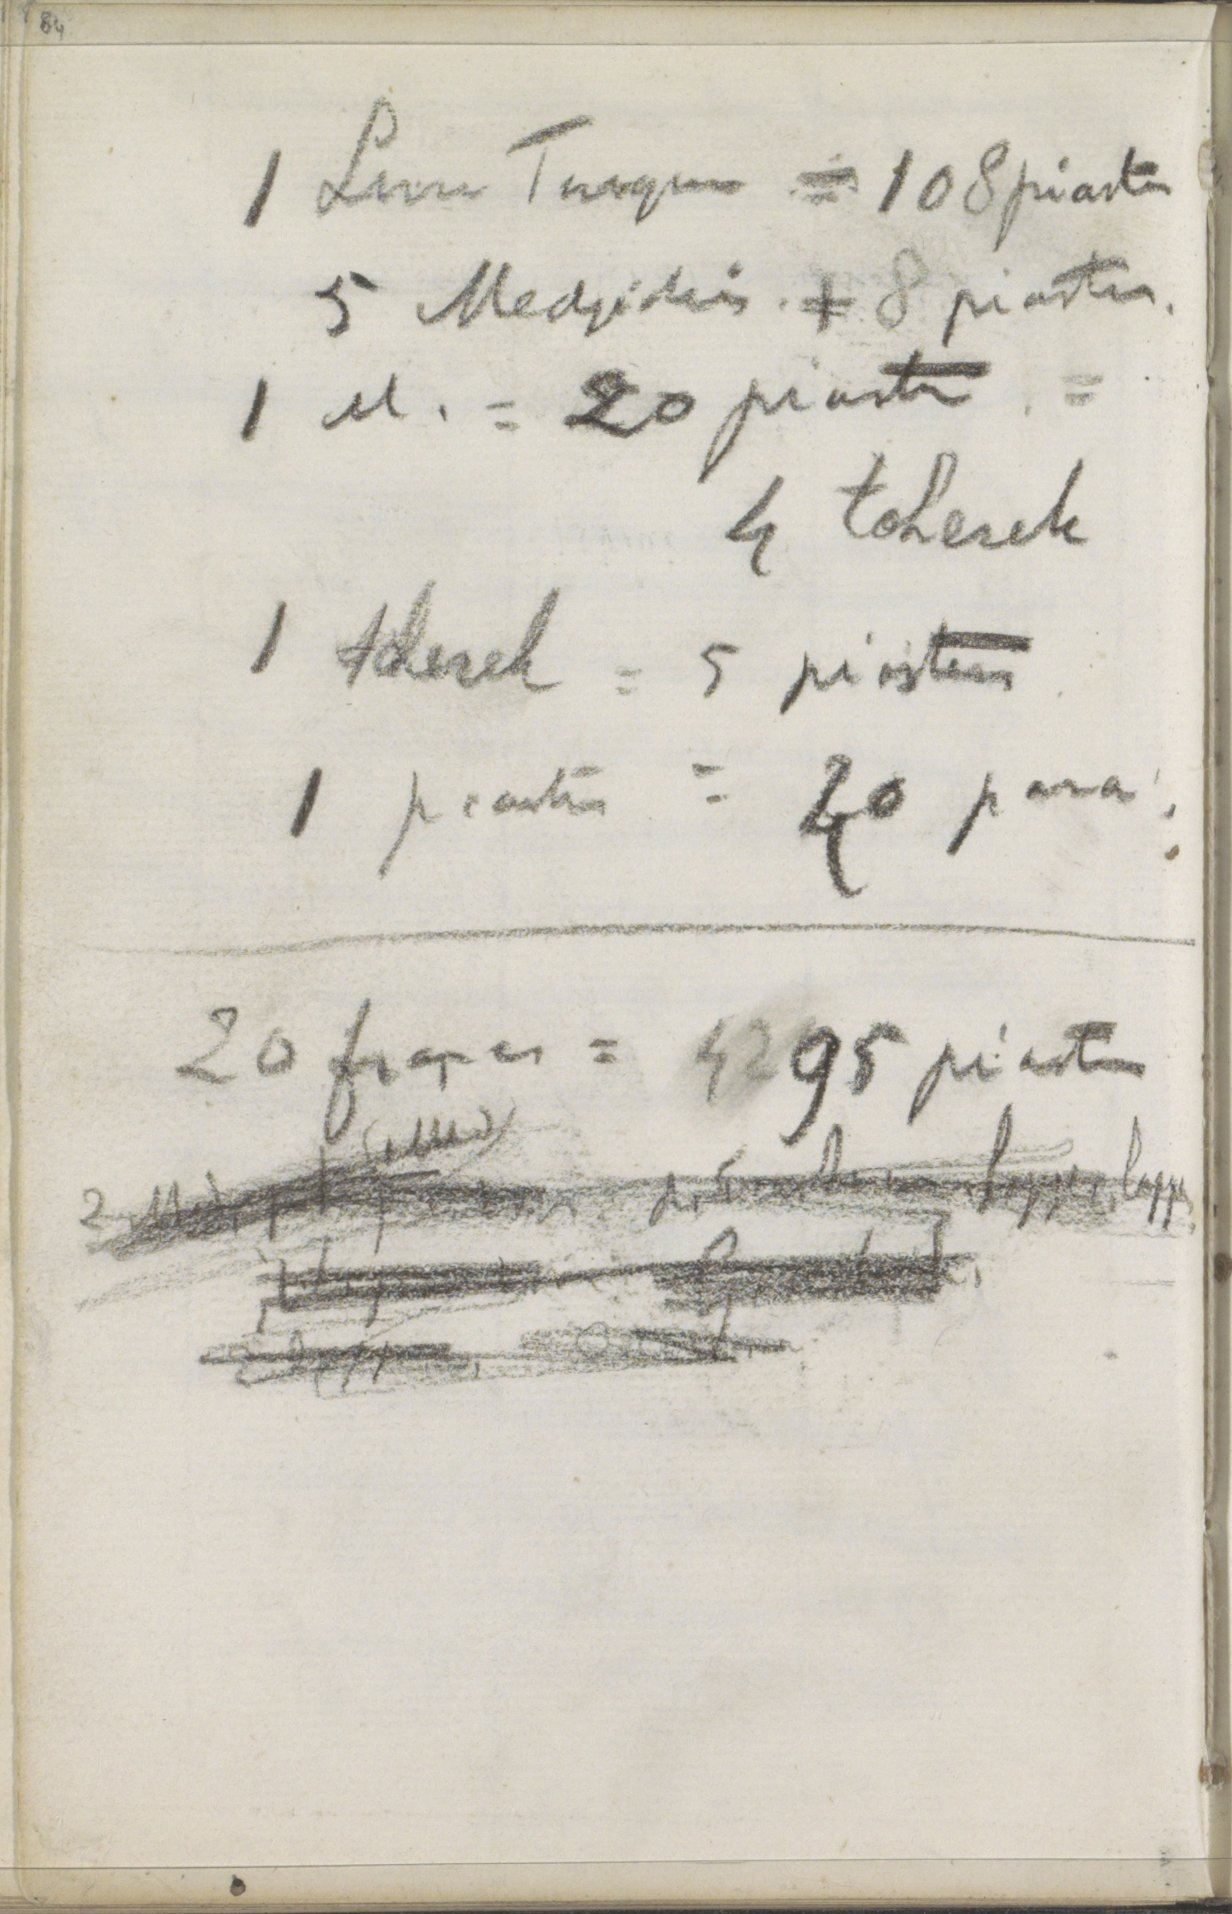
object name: sketchbook leaf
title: Blad met berekeningen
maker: marius bauer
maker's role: draughtsman, print maker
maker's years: 1867-1932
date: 1899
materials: chalk, paper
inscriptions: annotation: ‘[...]’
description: Pagina 84 uit een schetsboek met 42 bladen.